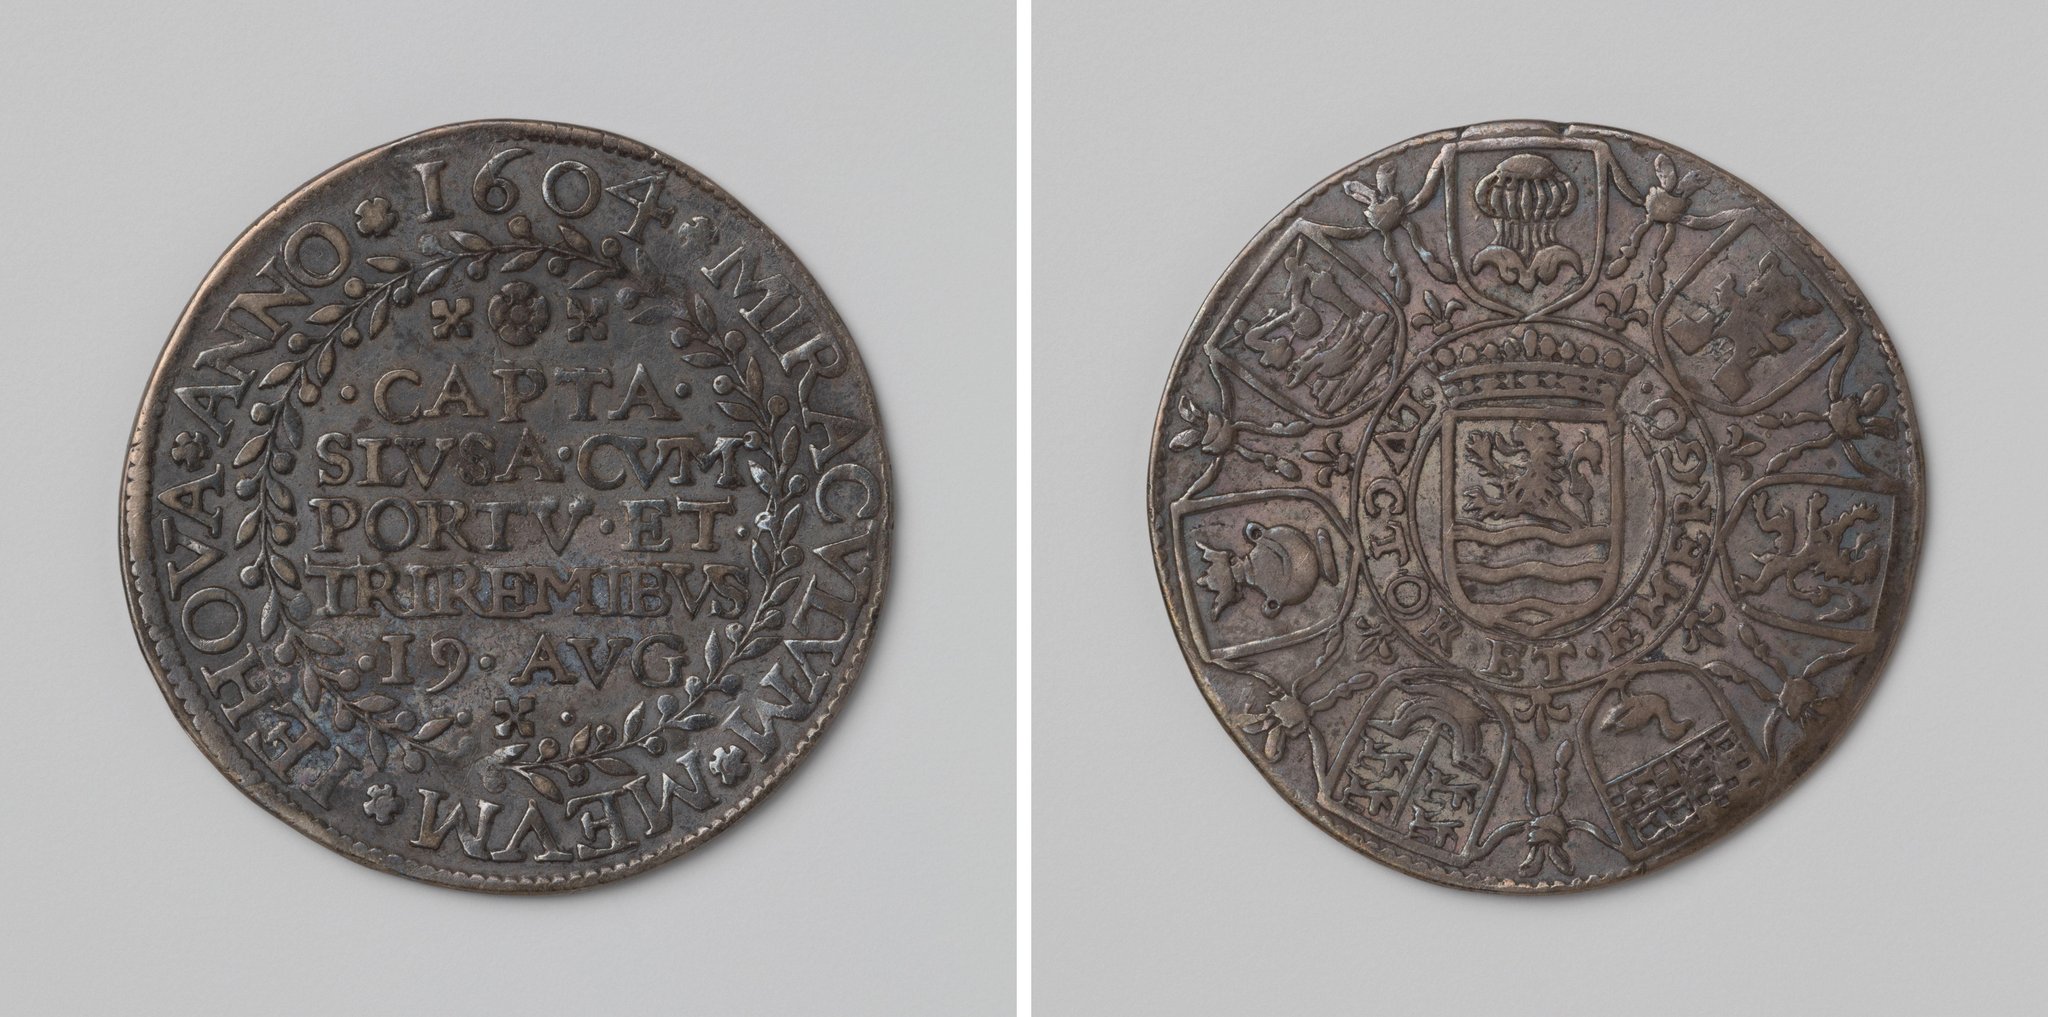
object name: jeton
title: Inname van Sluis met haven en vloot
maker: Anonymous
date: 1604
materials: silver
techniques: striking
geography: middelburg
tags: staten van zeeland, sluis, beleg en inname van sluis (1604)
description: Zilveren penning. Voorzijde: opschrift binnen lauwerkrans en omschrift. Keerzijde: gekroond wapenschild binnen omschrift en rand van zeven met lint verbonden wapenschilden